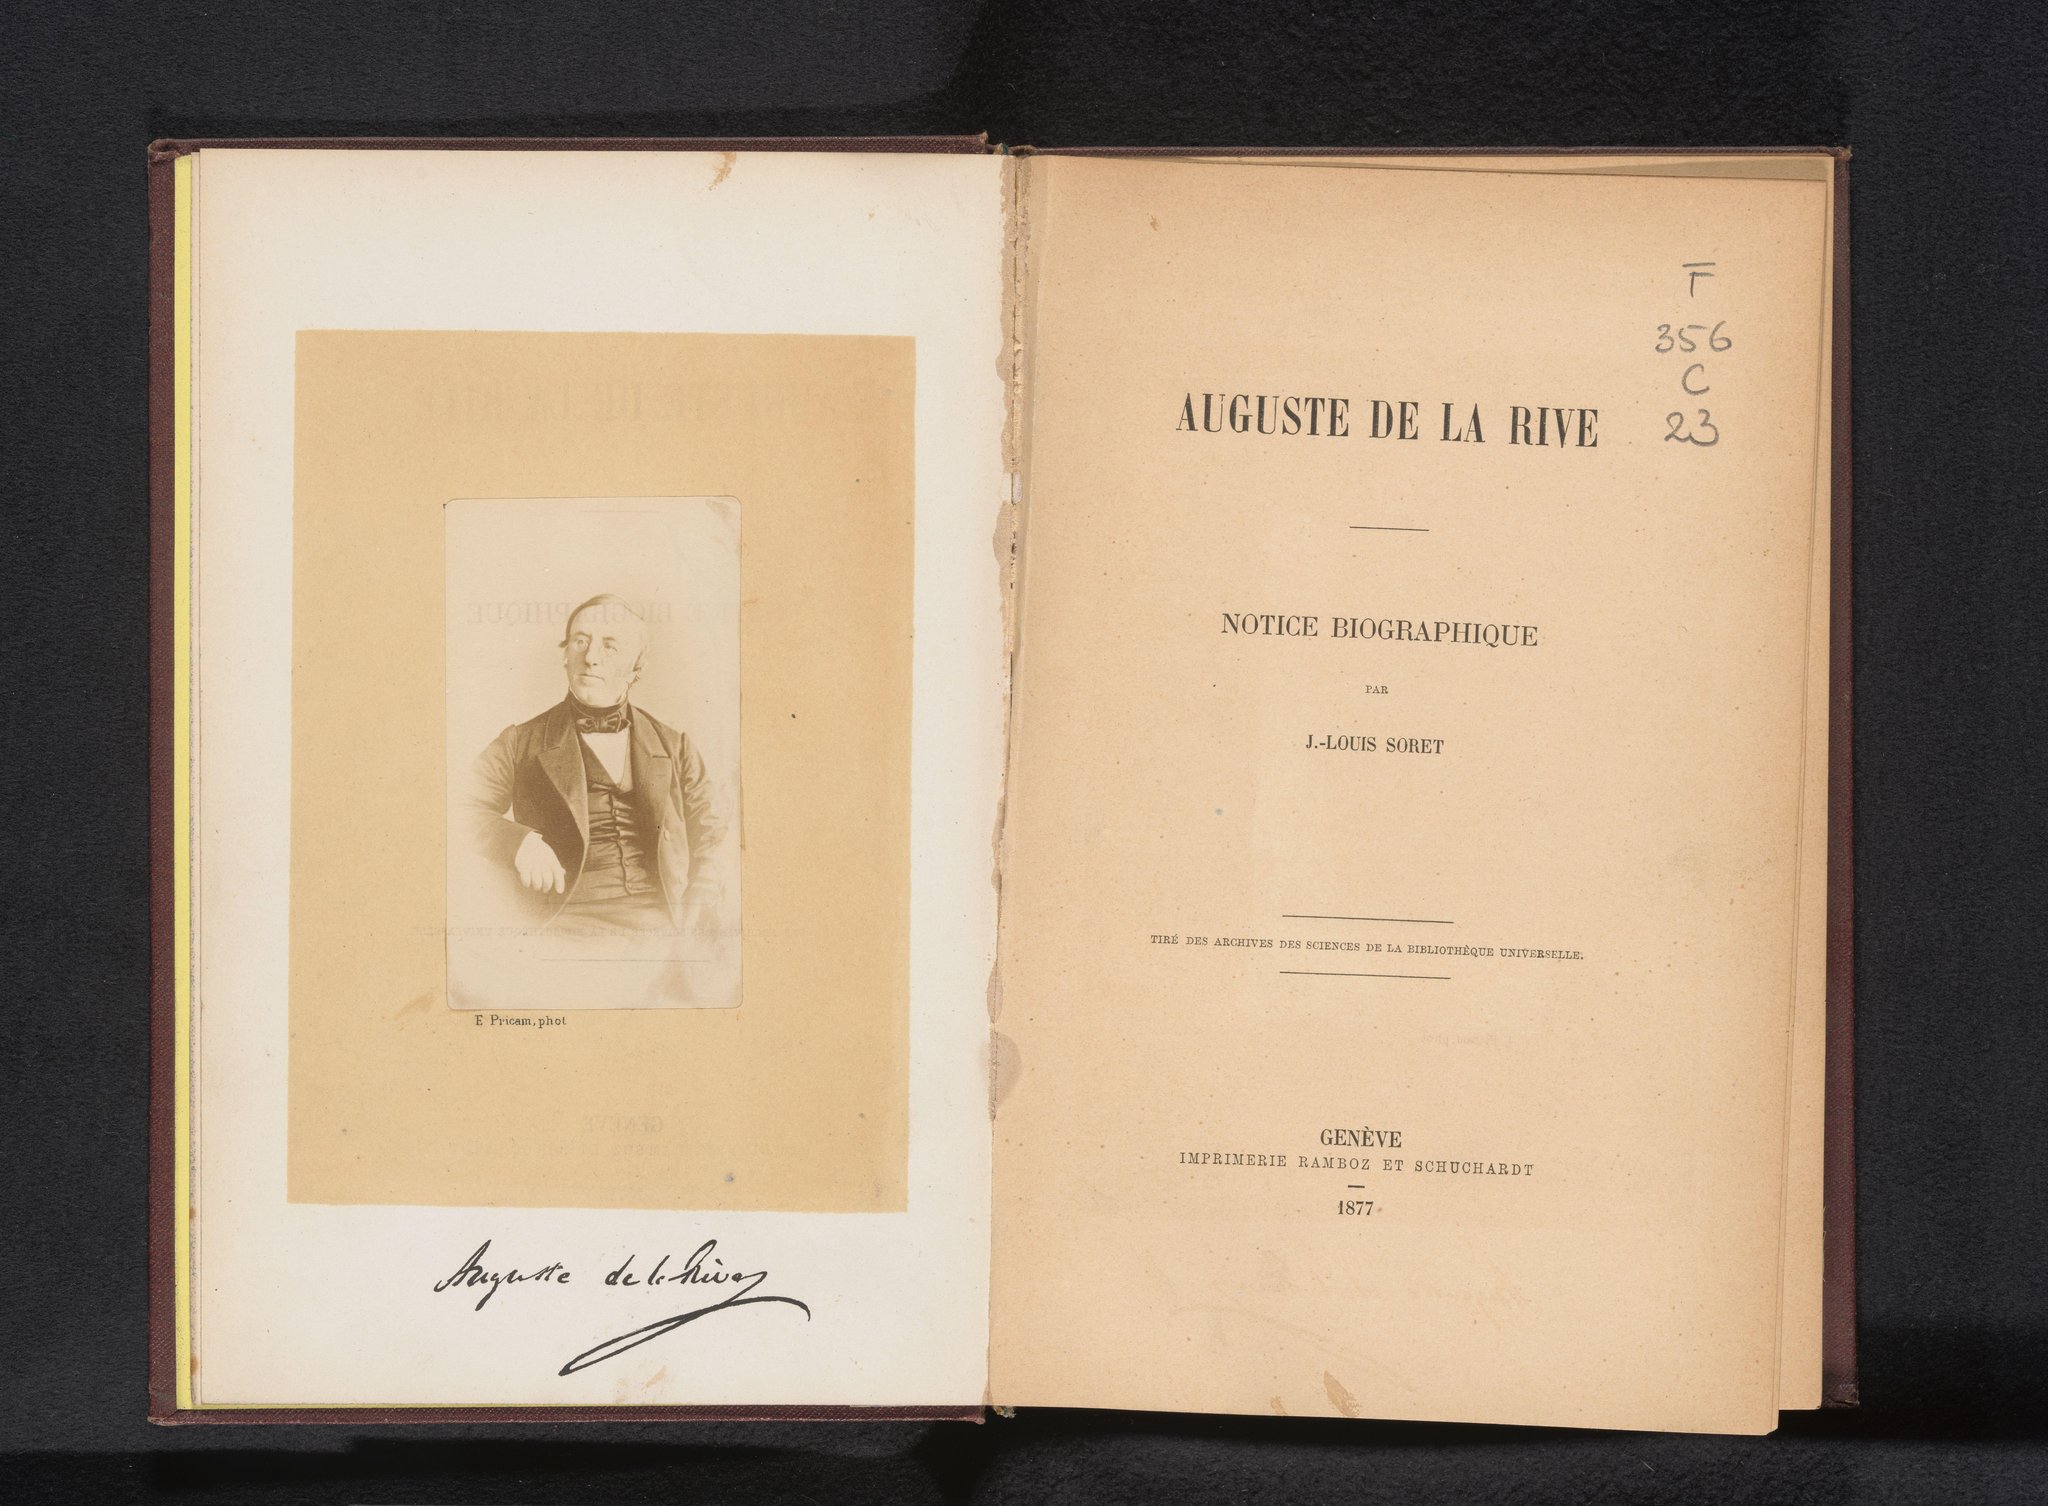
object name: page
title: Portret van Auguste Arthur de la Rive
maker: emile pricam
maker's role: fotograaf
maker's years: 1844-1919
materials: photographic support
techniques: albumen print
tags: physicist, historical persons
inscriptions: inscription: ‘Auguste de la Rive’